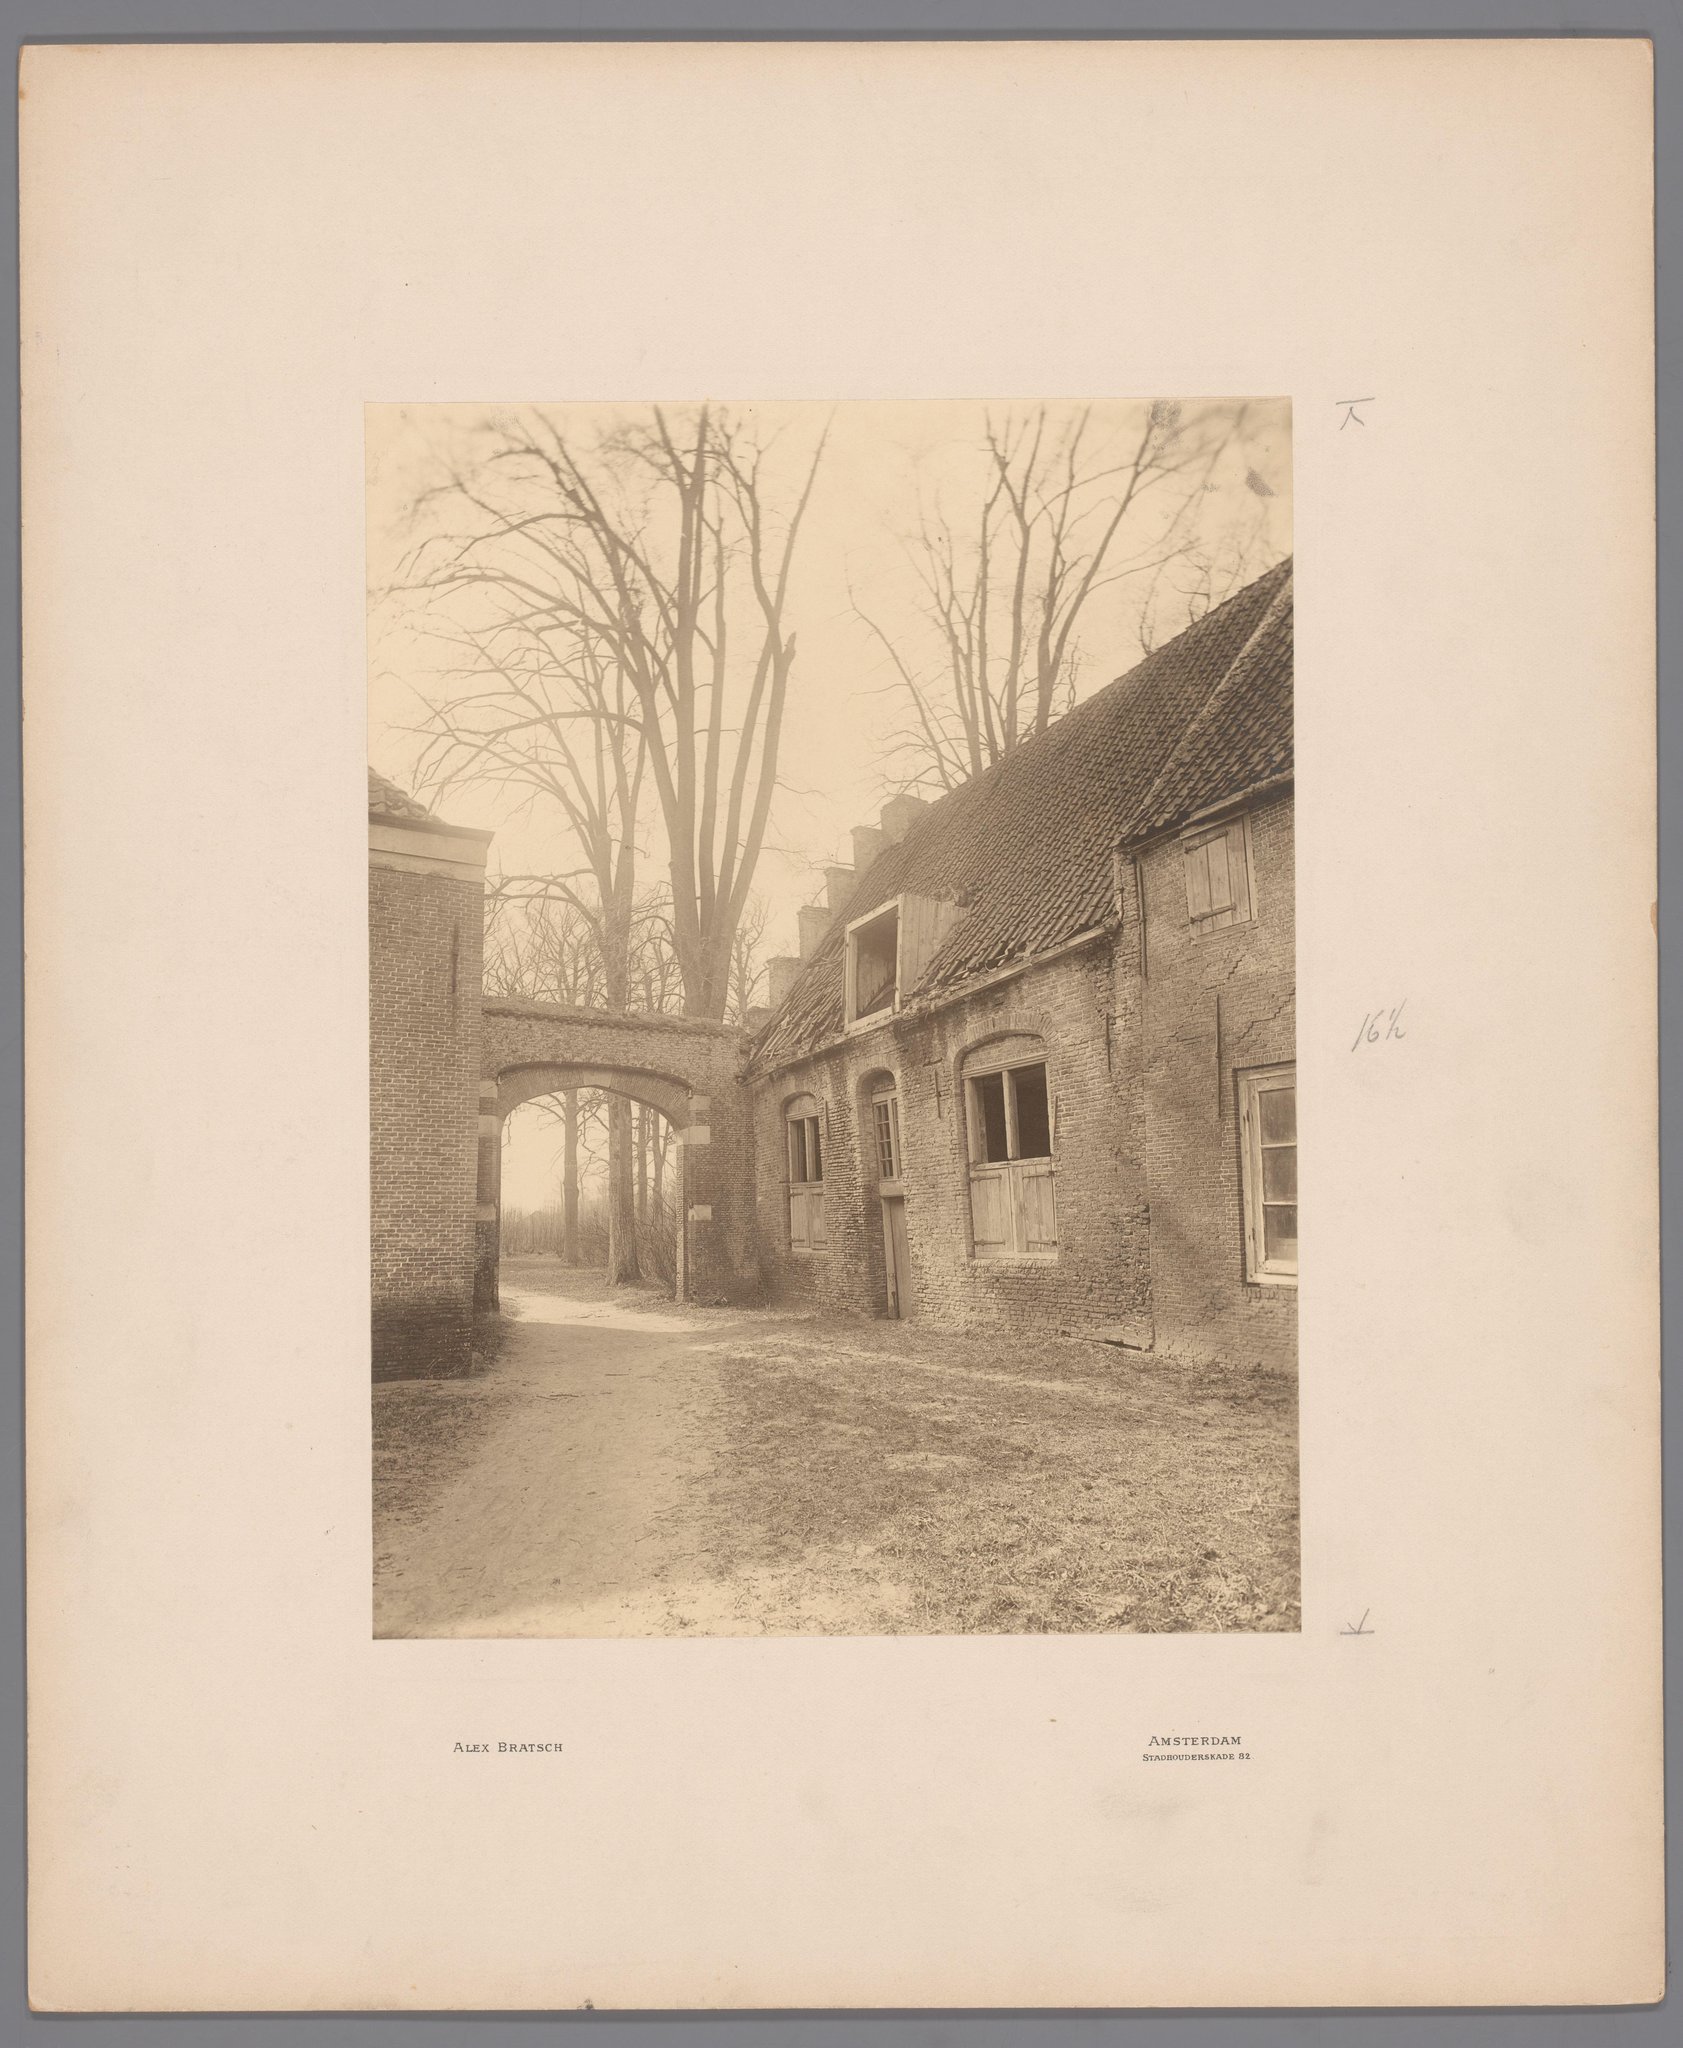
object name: photograph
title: Poort van Slot Assumburg bij Heemskerk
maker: alex bratsch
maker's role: fotograaf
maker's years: 1869-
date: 1910-1930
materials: cardboard, photographic support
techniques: gelatin silver print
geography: heemskerk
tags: castle, gate, entrance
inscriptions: annotation: ‘Assendelft/ Assendelft/ Assumburg Heemskerk NH/ No 7’, annotation: ‘16 1/2’, number: ‘118’, address: ‘Amsterdam/ Stadhouderskade 82’